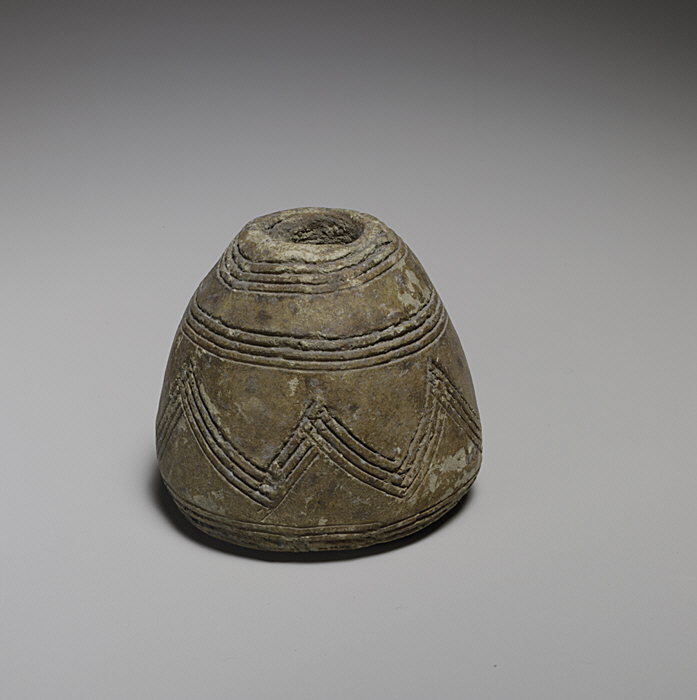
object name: spindle whorl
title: Terracotta conical-hemispherical spindle-whorl with flat base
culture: cypriot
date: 2000-1725 BCE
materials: terracotta